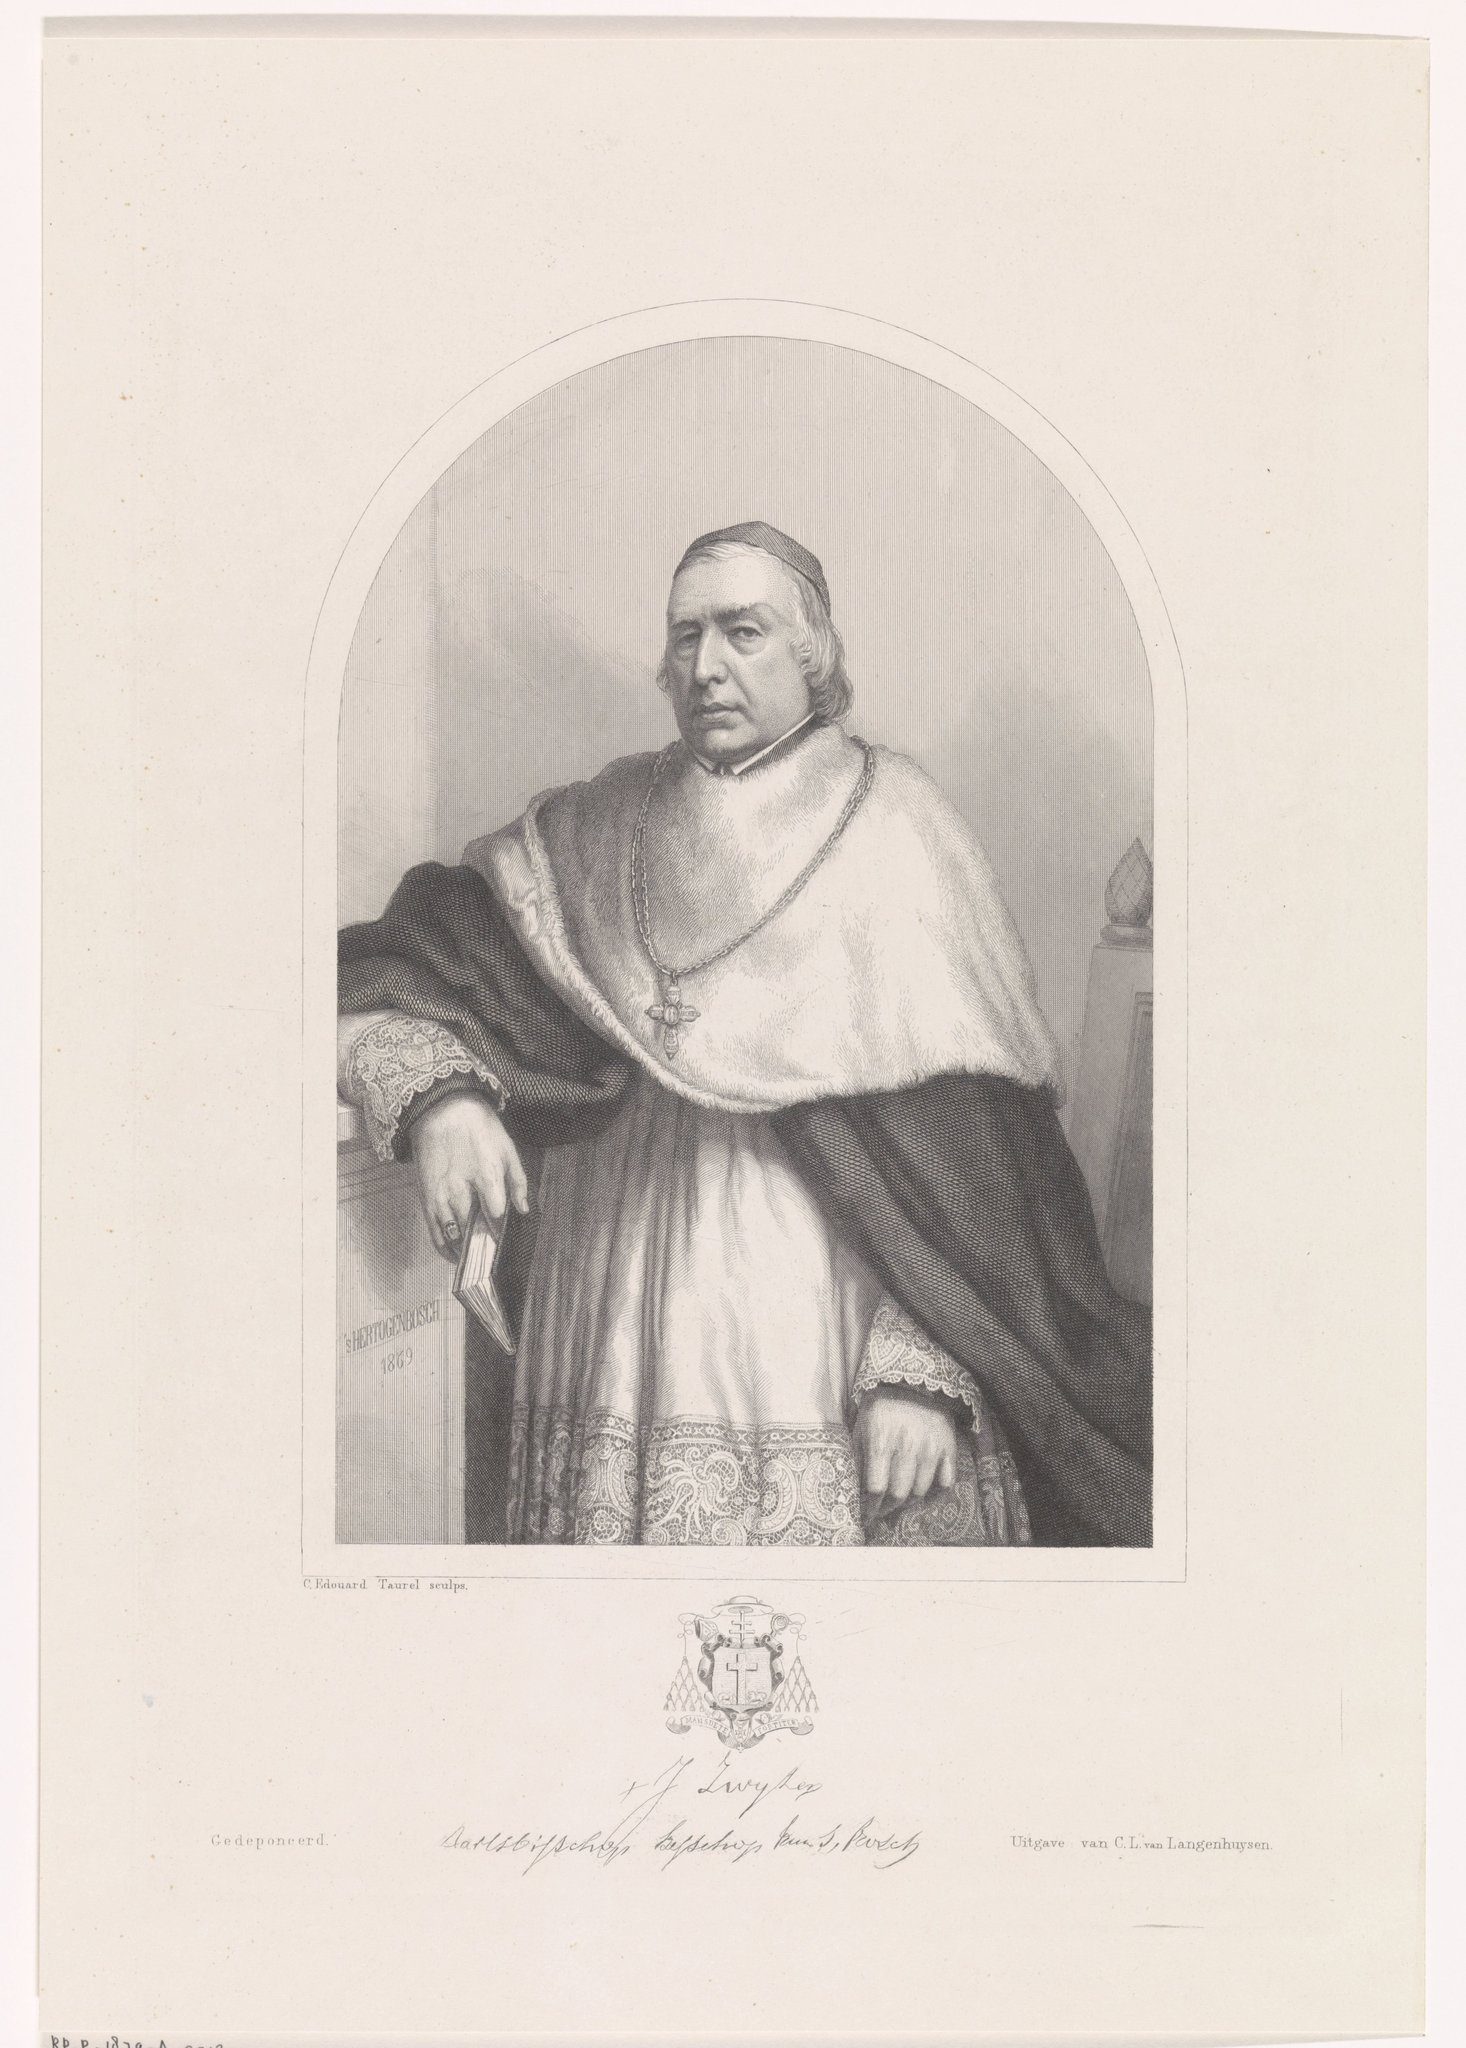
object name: print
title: Portret van Johannes Swijzen, aartsbisschop van Utrecht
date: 1869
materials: paper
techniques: engraving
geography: amsterdam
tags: tilburg, aartsbisschop, johannes zwijsen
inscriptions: name: ‘J. Zwijsen/ aartsbisschop bisschop [...]’, collector's mark: Lugt 2228